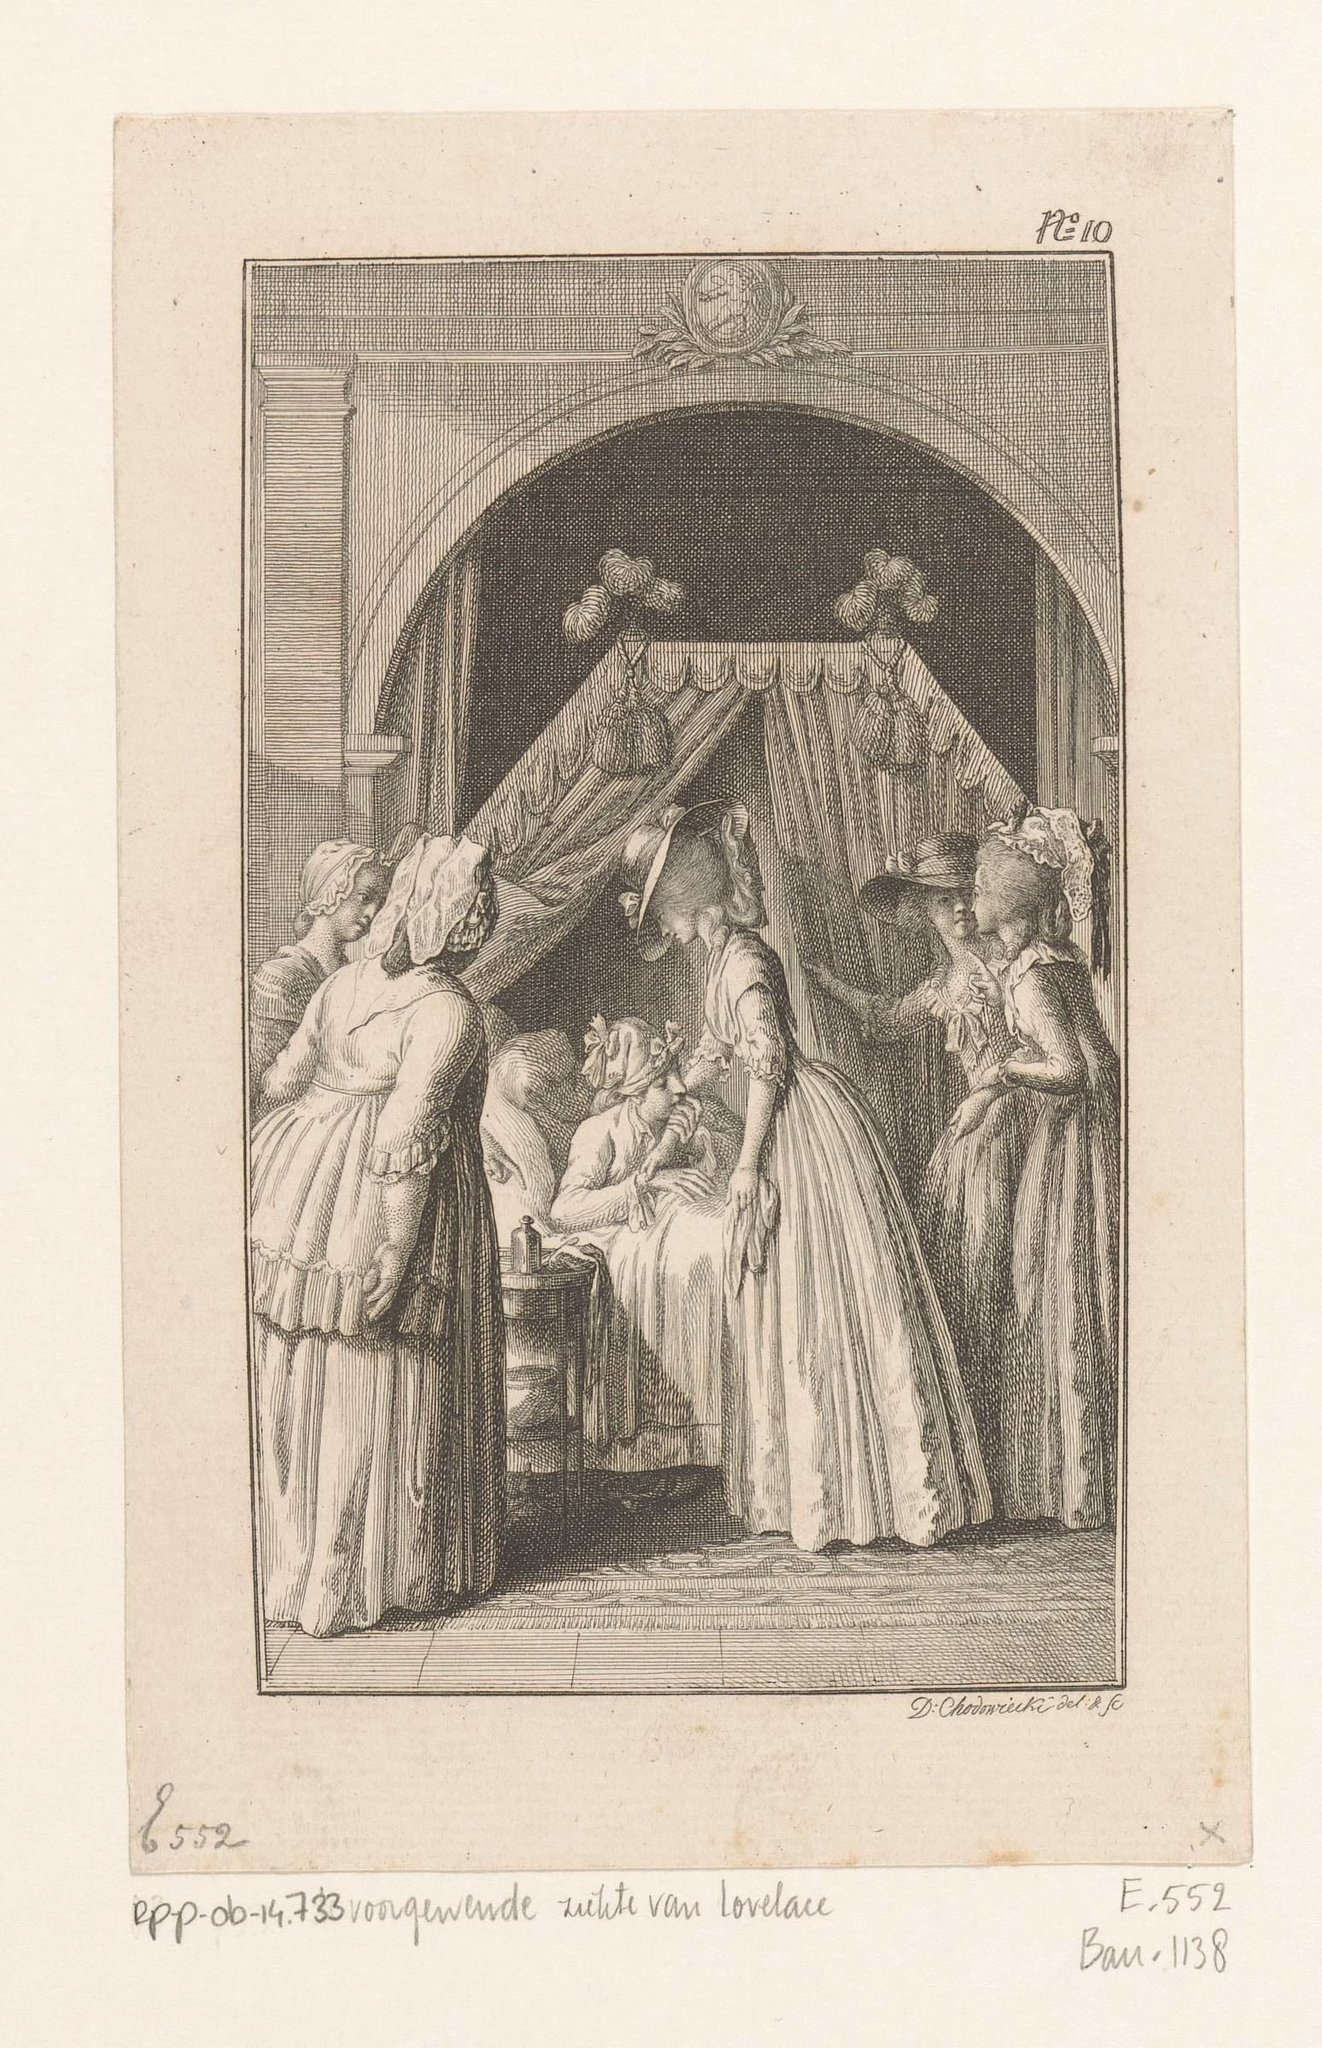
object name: print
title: Lovelace doet alsof hij ziek is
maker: daniel nikolaus chodowiecki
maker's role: draughtsman, print maker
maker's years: 1726-1801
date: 1784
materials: paper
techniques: etching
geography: berlin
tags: literature, patient, sick person, kissing the hand (lovers)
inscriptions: collector's mark: Lugt 2228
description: Prent gebruikt voor: Richardson, Samuel. Clarisse Harlowe, Traduction nouvelle et seule complete par (...). 14 dln. Genève en Parijs: Barde, 1785-87.